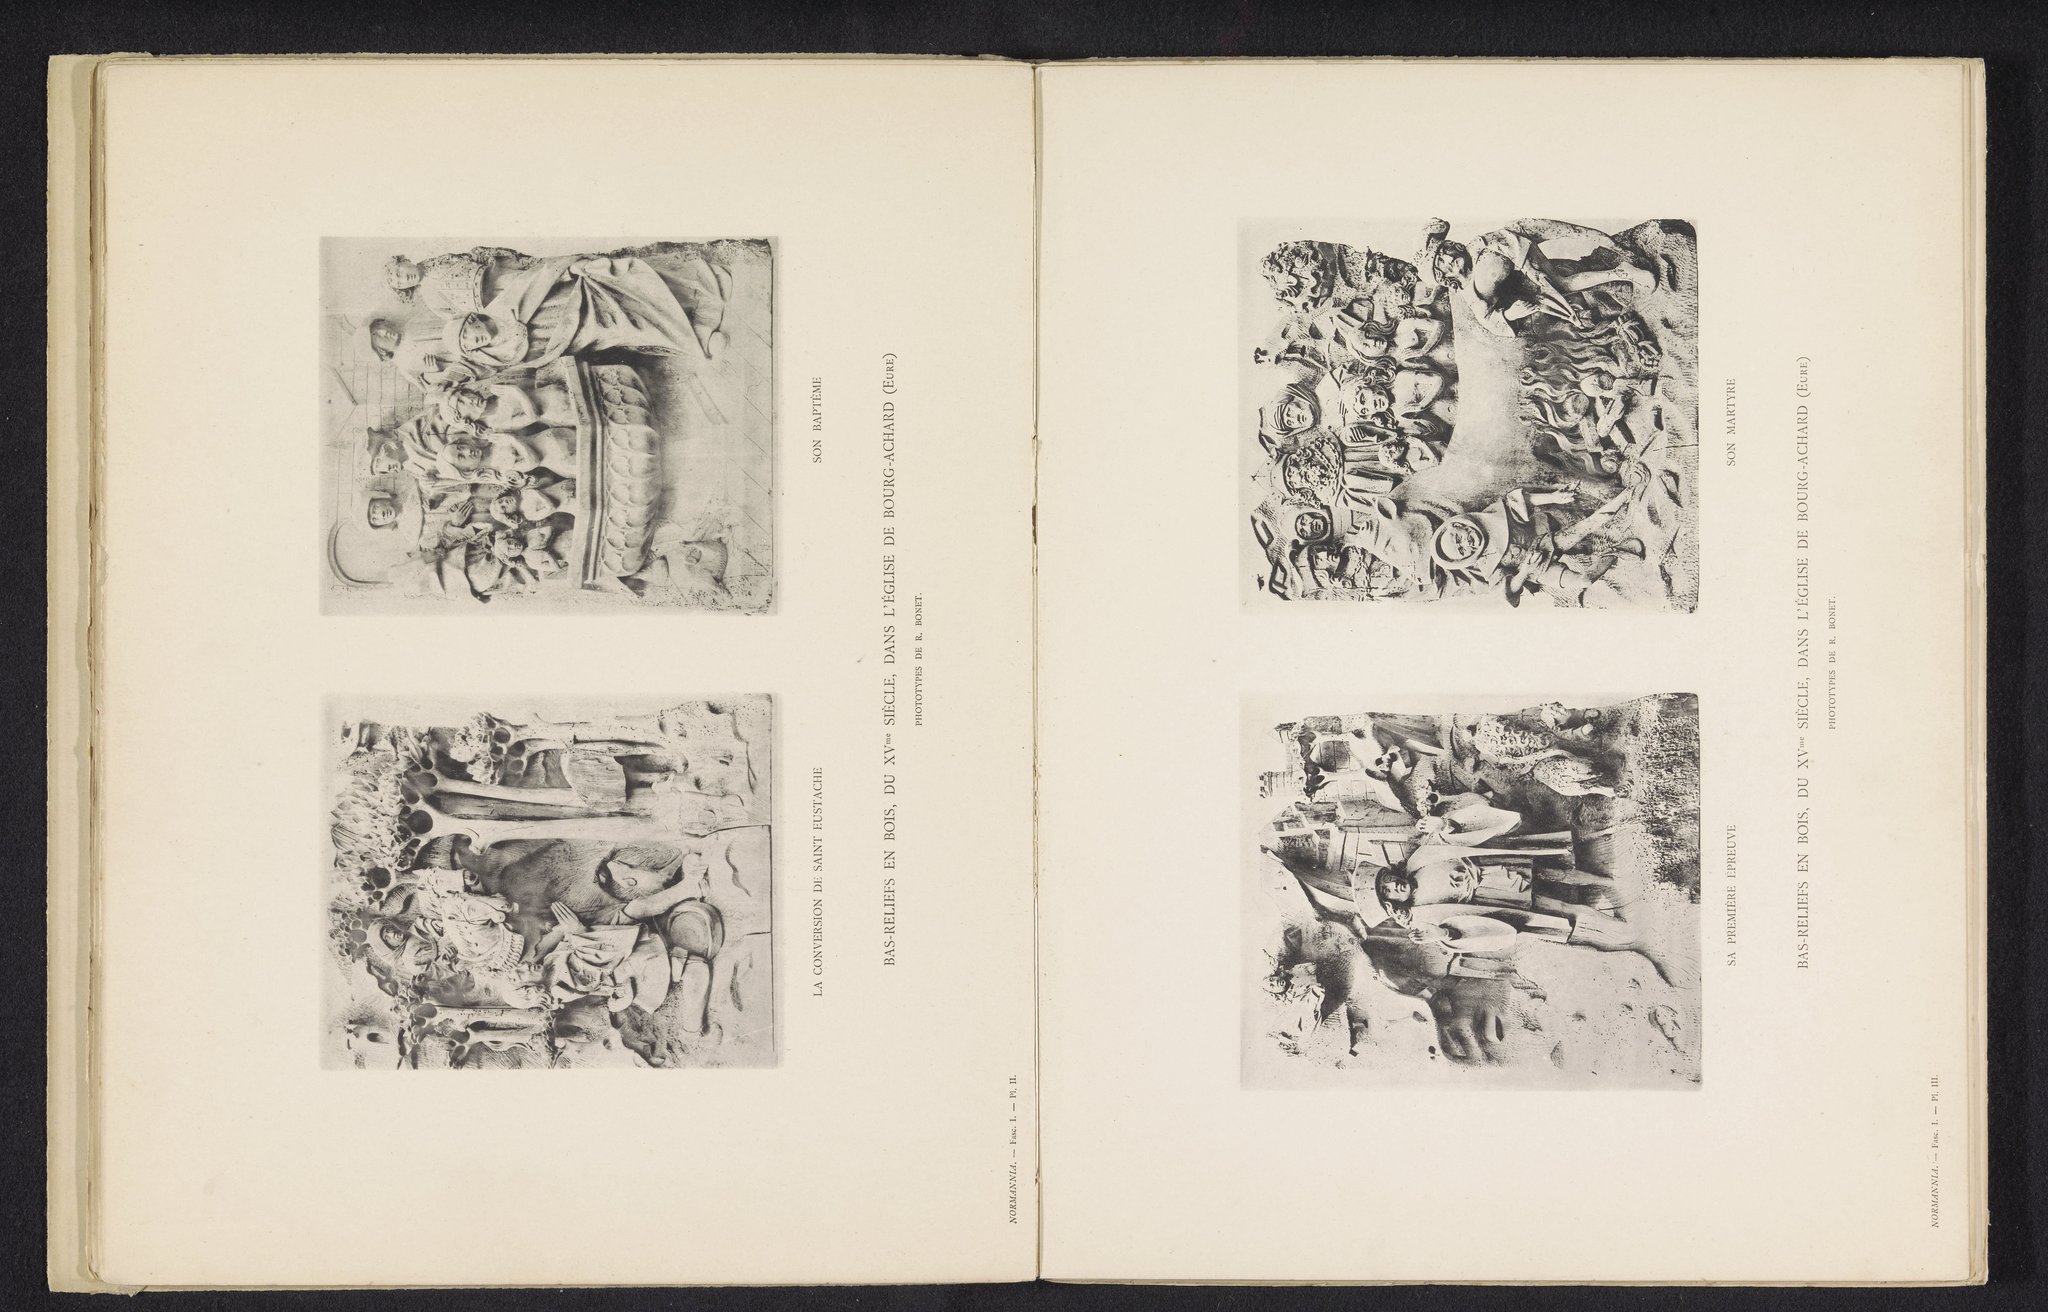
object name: page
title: Bas reliefs en bois, du XVme siècle, dans l'Église de Bourg-Achard (Eure)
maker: raoul bonet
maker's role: fotograaf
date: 1885-1895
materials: paper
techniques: photograph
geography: bourg-achard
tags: the roman soldier and hunter eustace (eustachius, eustathius); possible attributes: banner, bull of brass, cuirass, hunting horn, lance, stag's head with crucifix, sword, two sons, wife, martyrdom, suffering, misfortune, death of st. eustace, sculpture (+ relief ~ sculpture)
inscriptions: number: ‘Pl. III.’